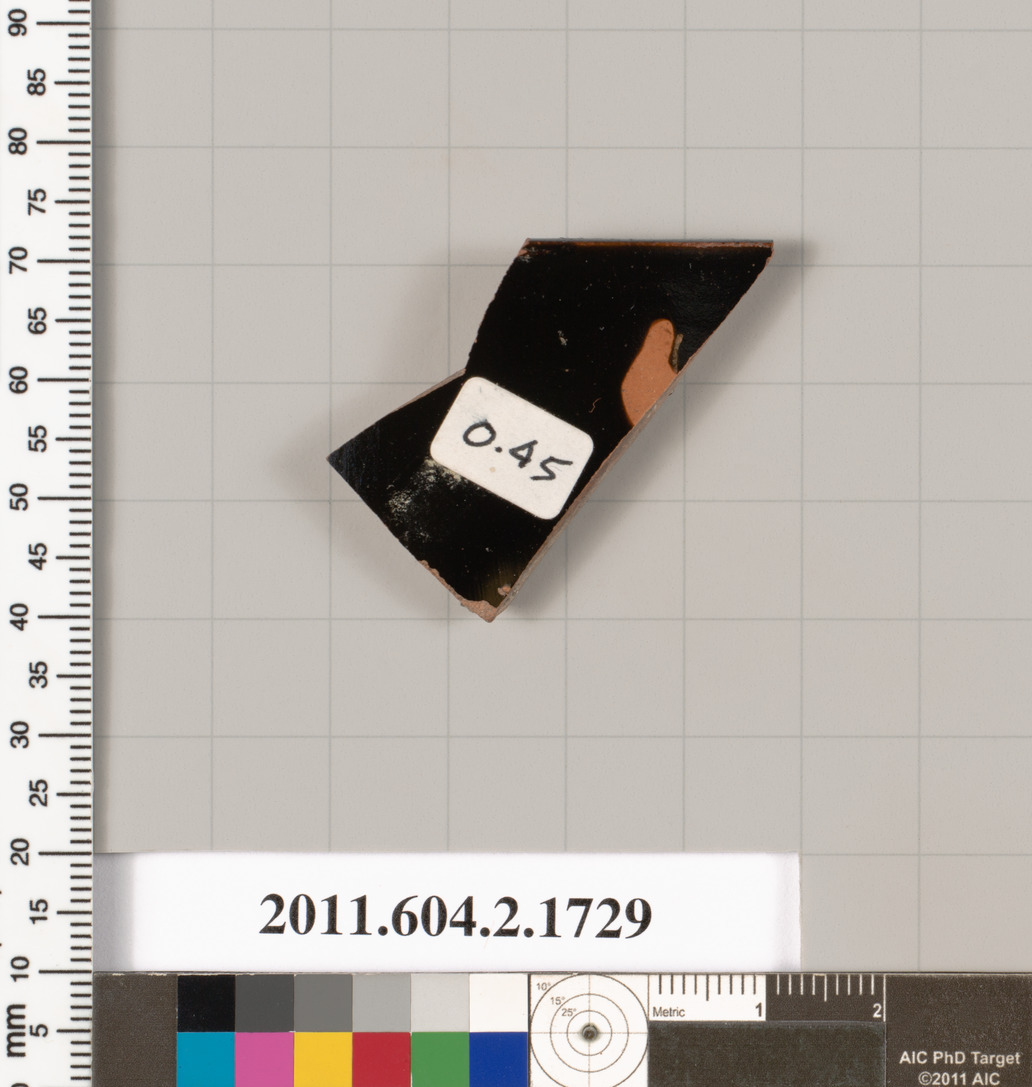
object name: skyphos fragment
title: Terracotta rim fragment of a skyphos (deep drinking cup)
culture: greek, attic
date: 475-451 BCE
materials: terracotta